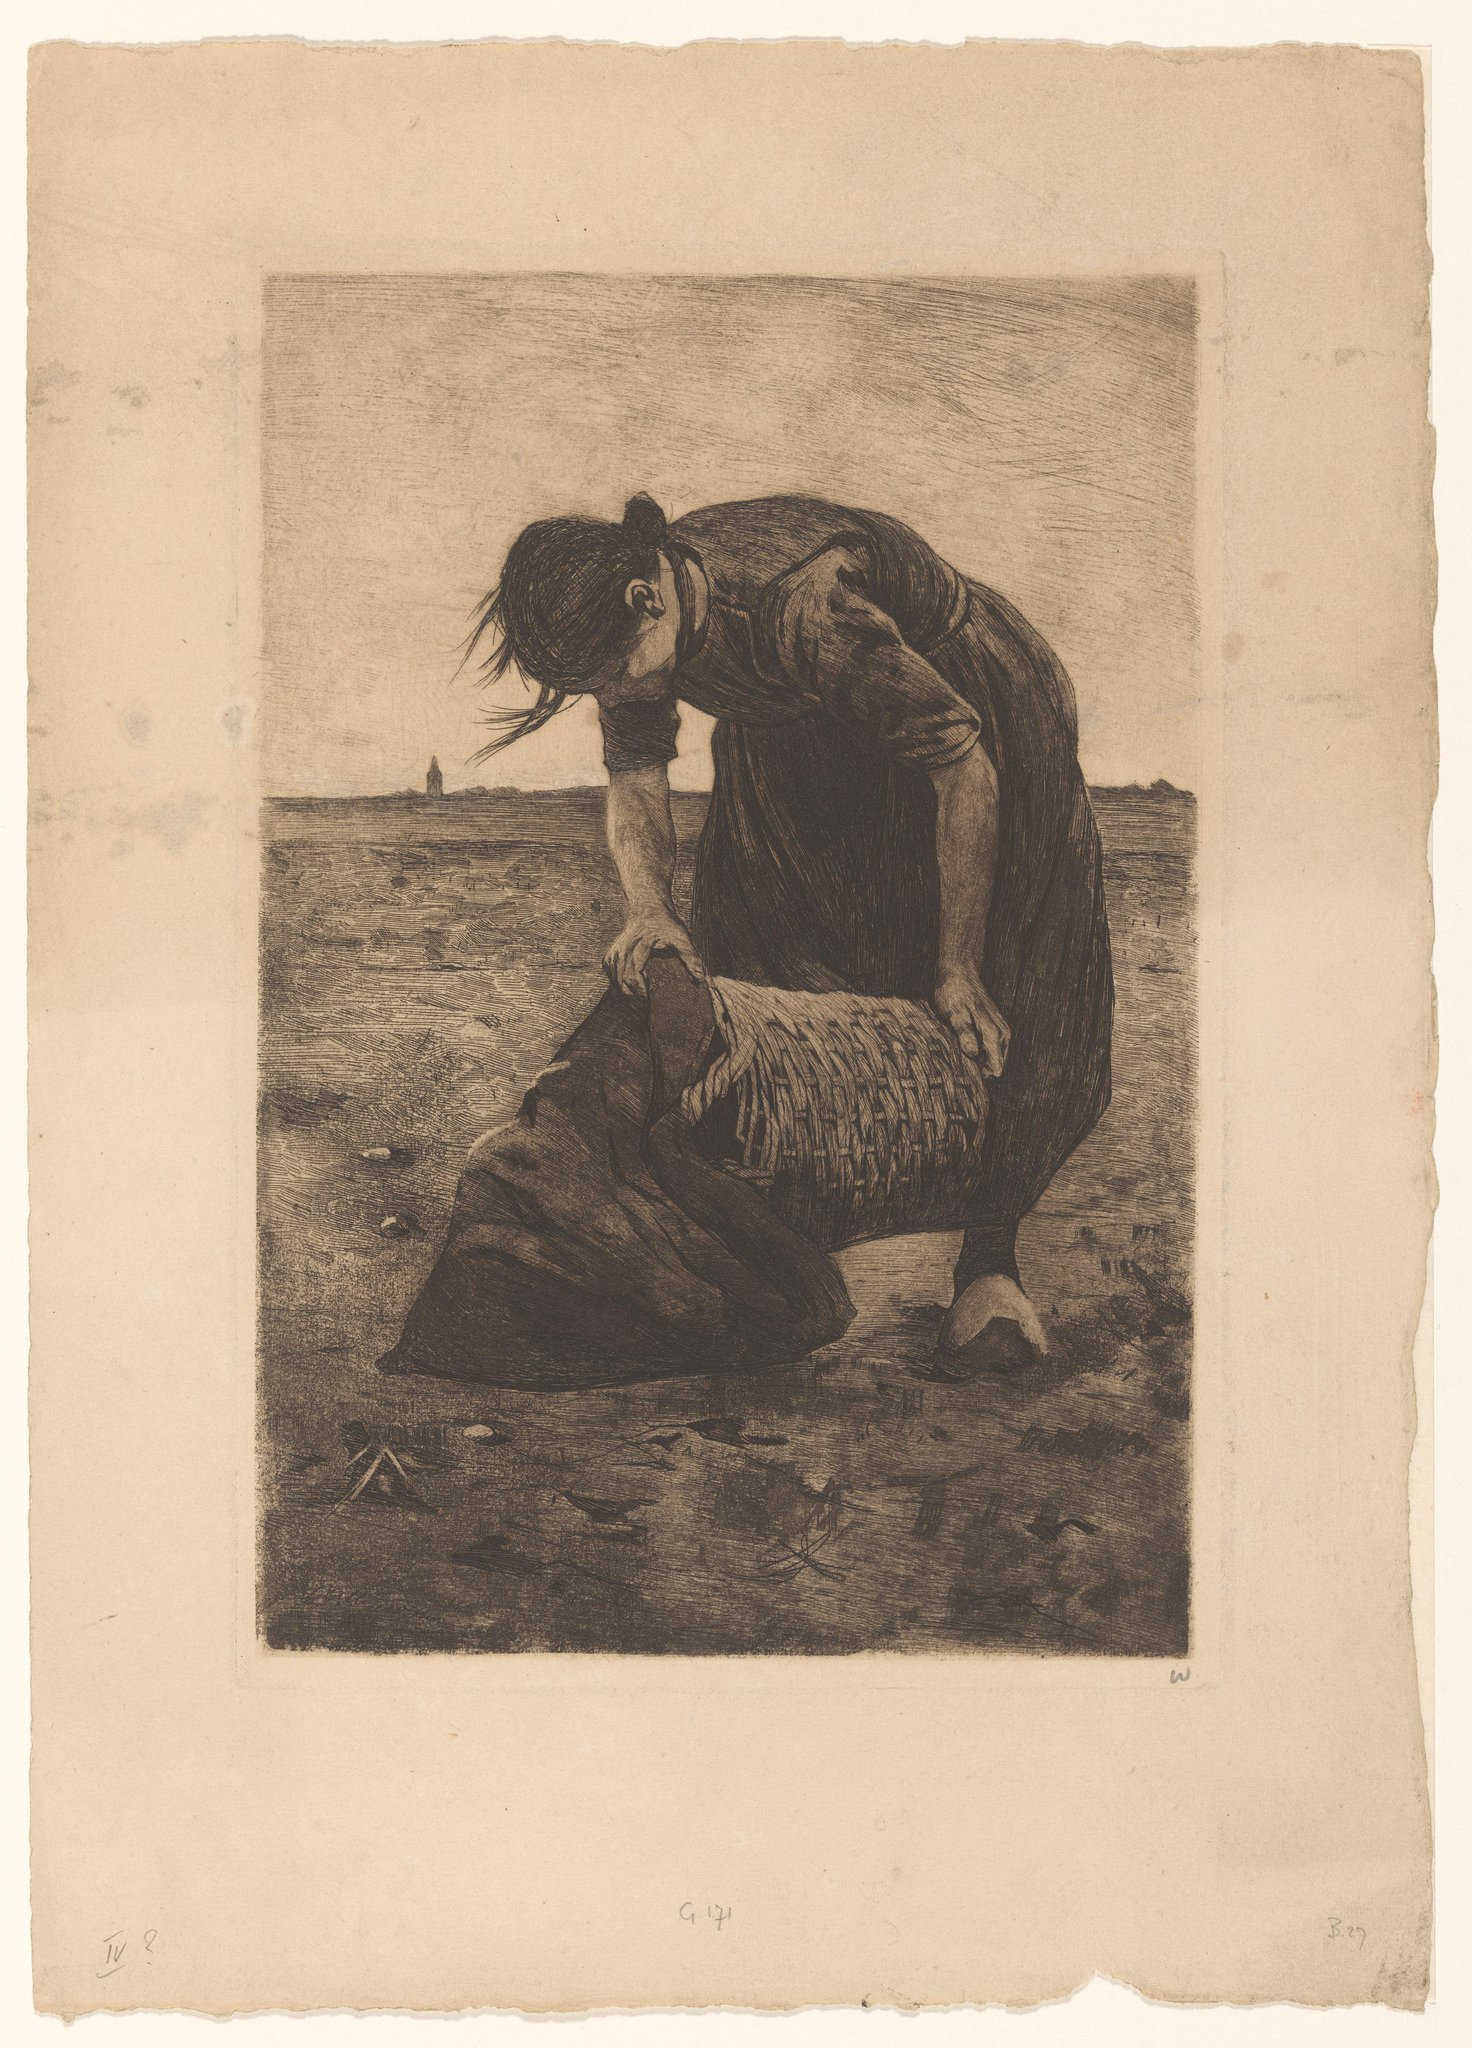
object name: print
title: Voorovergebogen aardappelrooister met een mand en zak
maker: willem witsen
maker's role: draughtsman, painter, print maker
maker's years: 1860-1923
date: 1886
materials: paper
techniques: etching, intaglio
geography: ewijkshoeve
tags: harvest, farmers - aa - female farmer, farmer's wife, potatoes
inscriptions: collector's mark: Lugt 2228, monogram: ‘W’